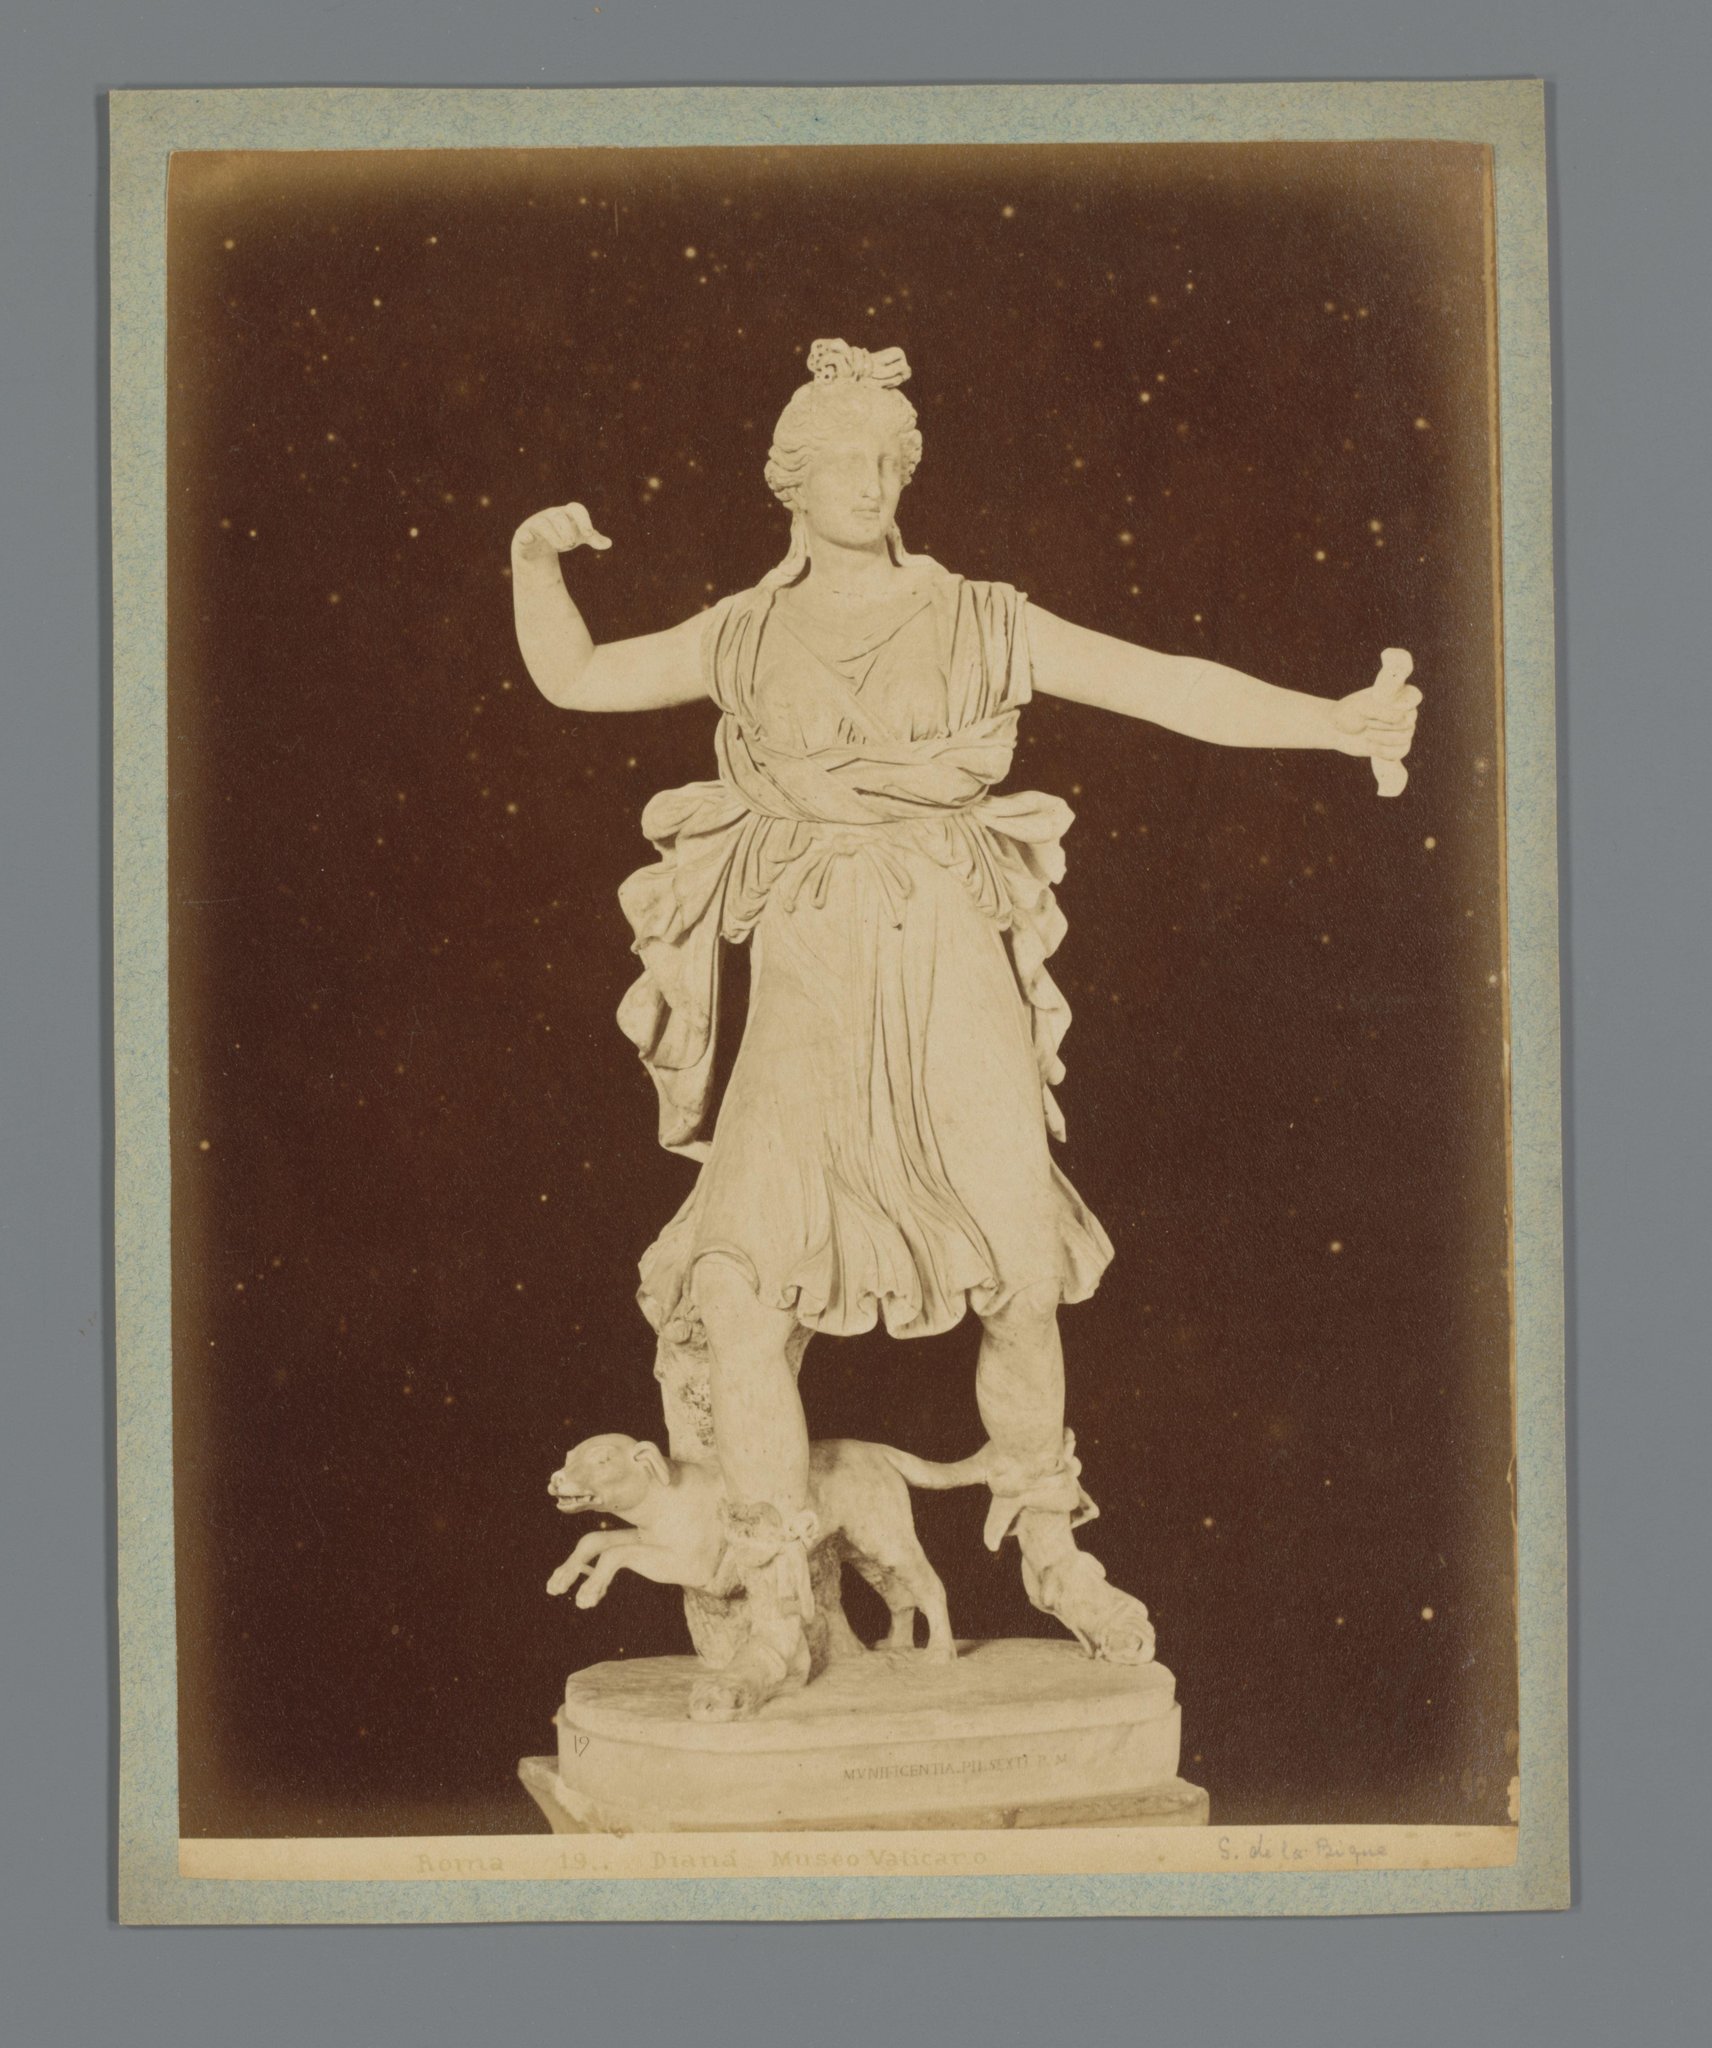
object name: photograph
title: Standbeeld van Diana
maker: Anonymous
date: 1851-1900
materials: cardboard, paper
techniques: albumen print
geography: vatican city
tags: monument, statue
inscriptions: inscription: ‘S. de la Bique’, collector's mark: ‘VOSMAER’, number: ‘19..’